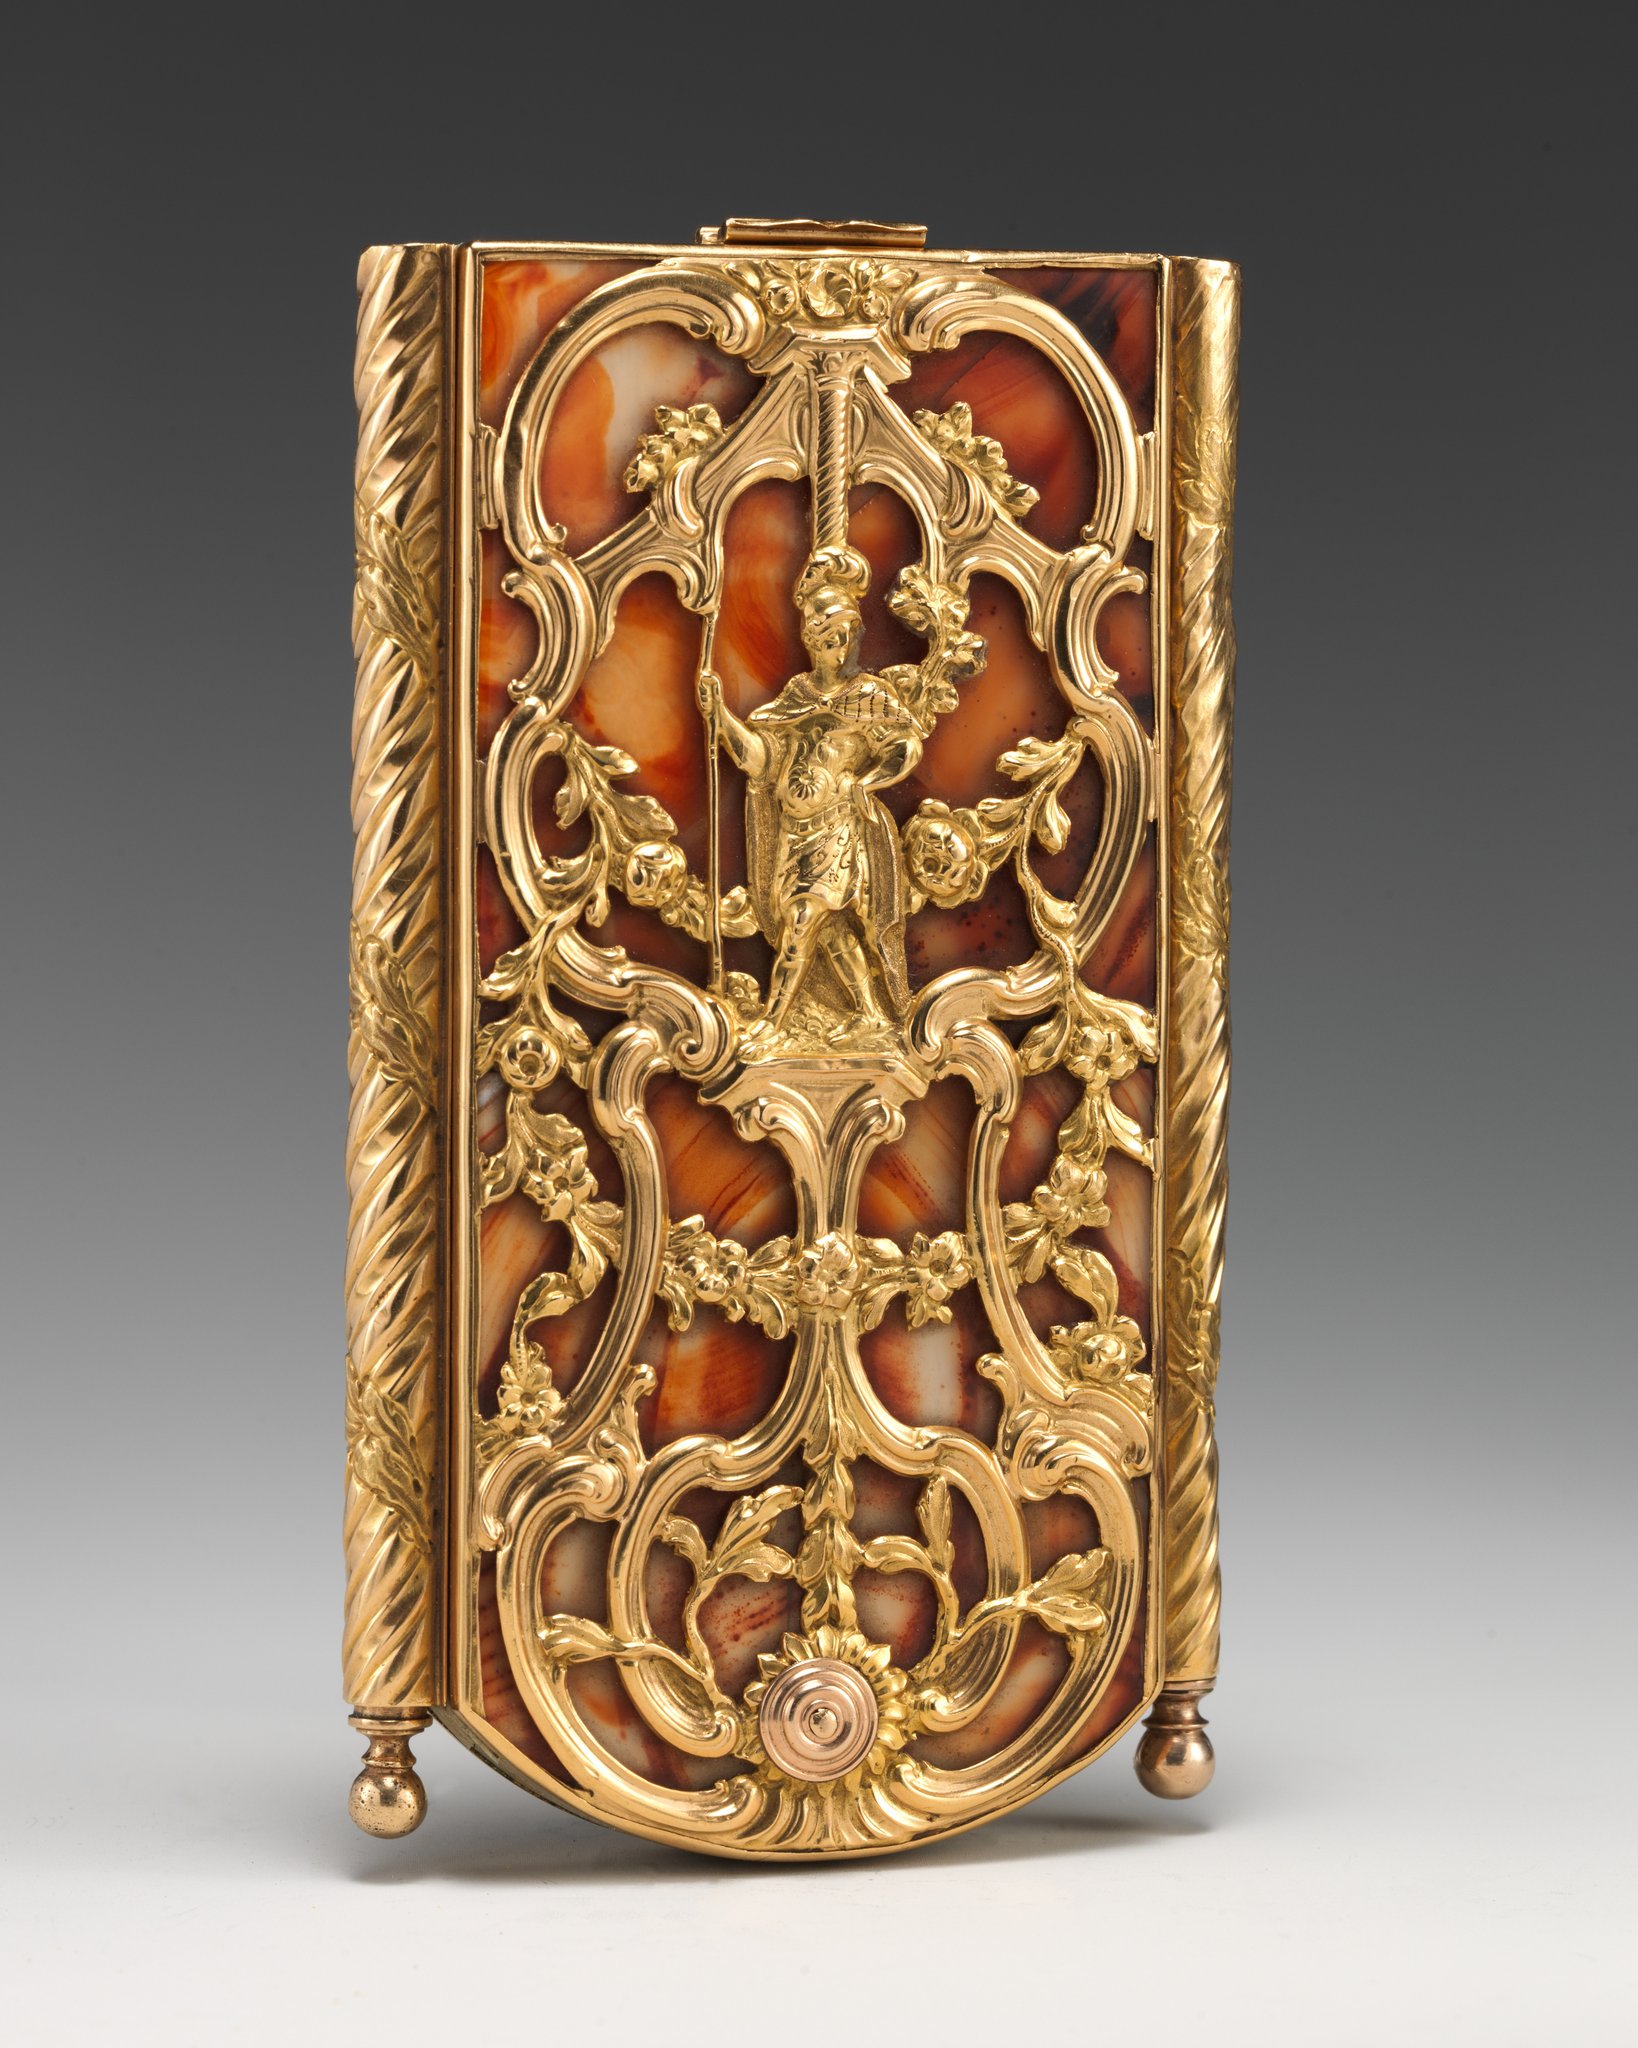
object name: souvenir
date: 1734-1766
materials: stone, gold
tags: human figures